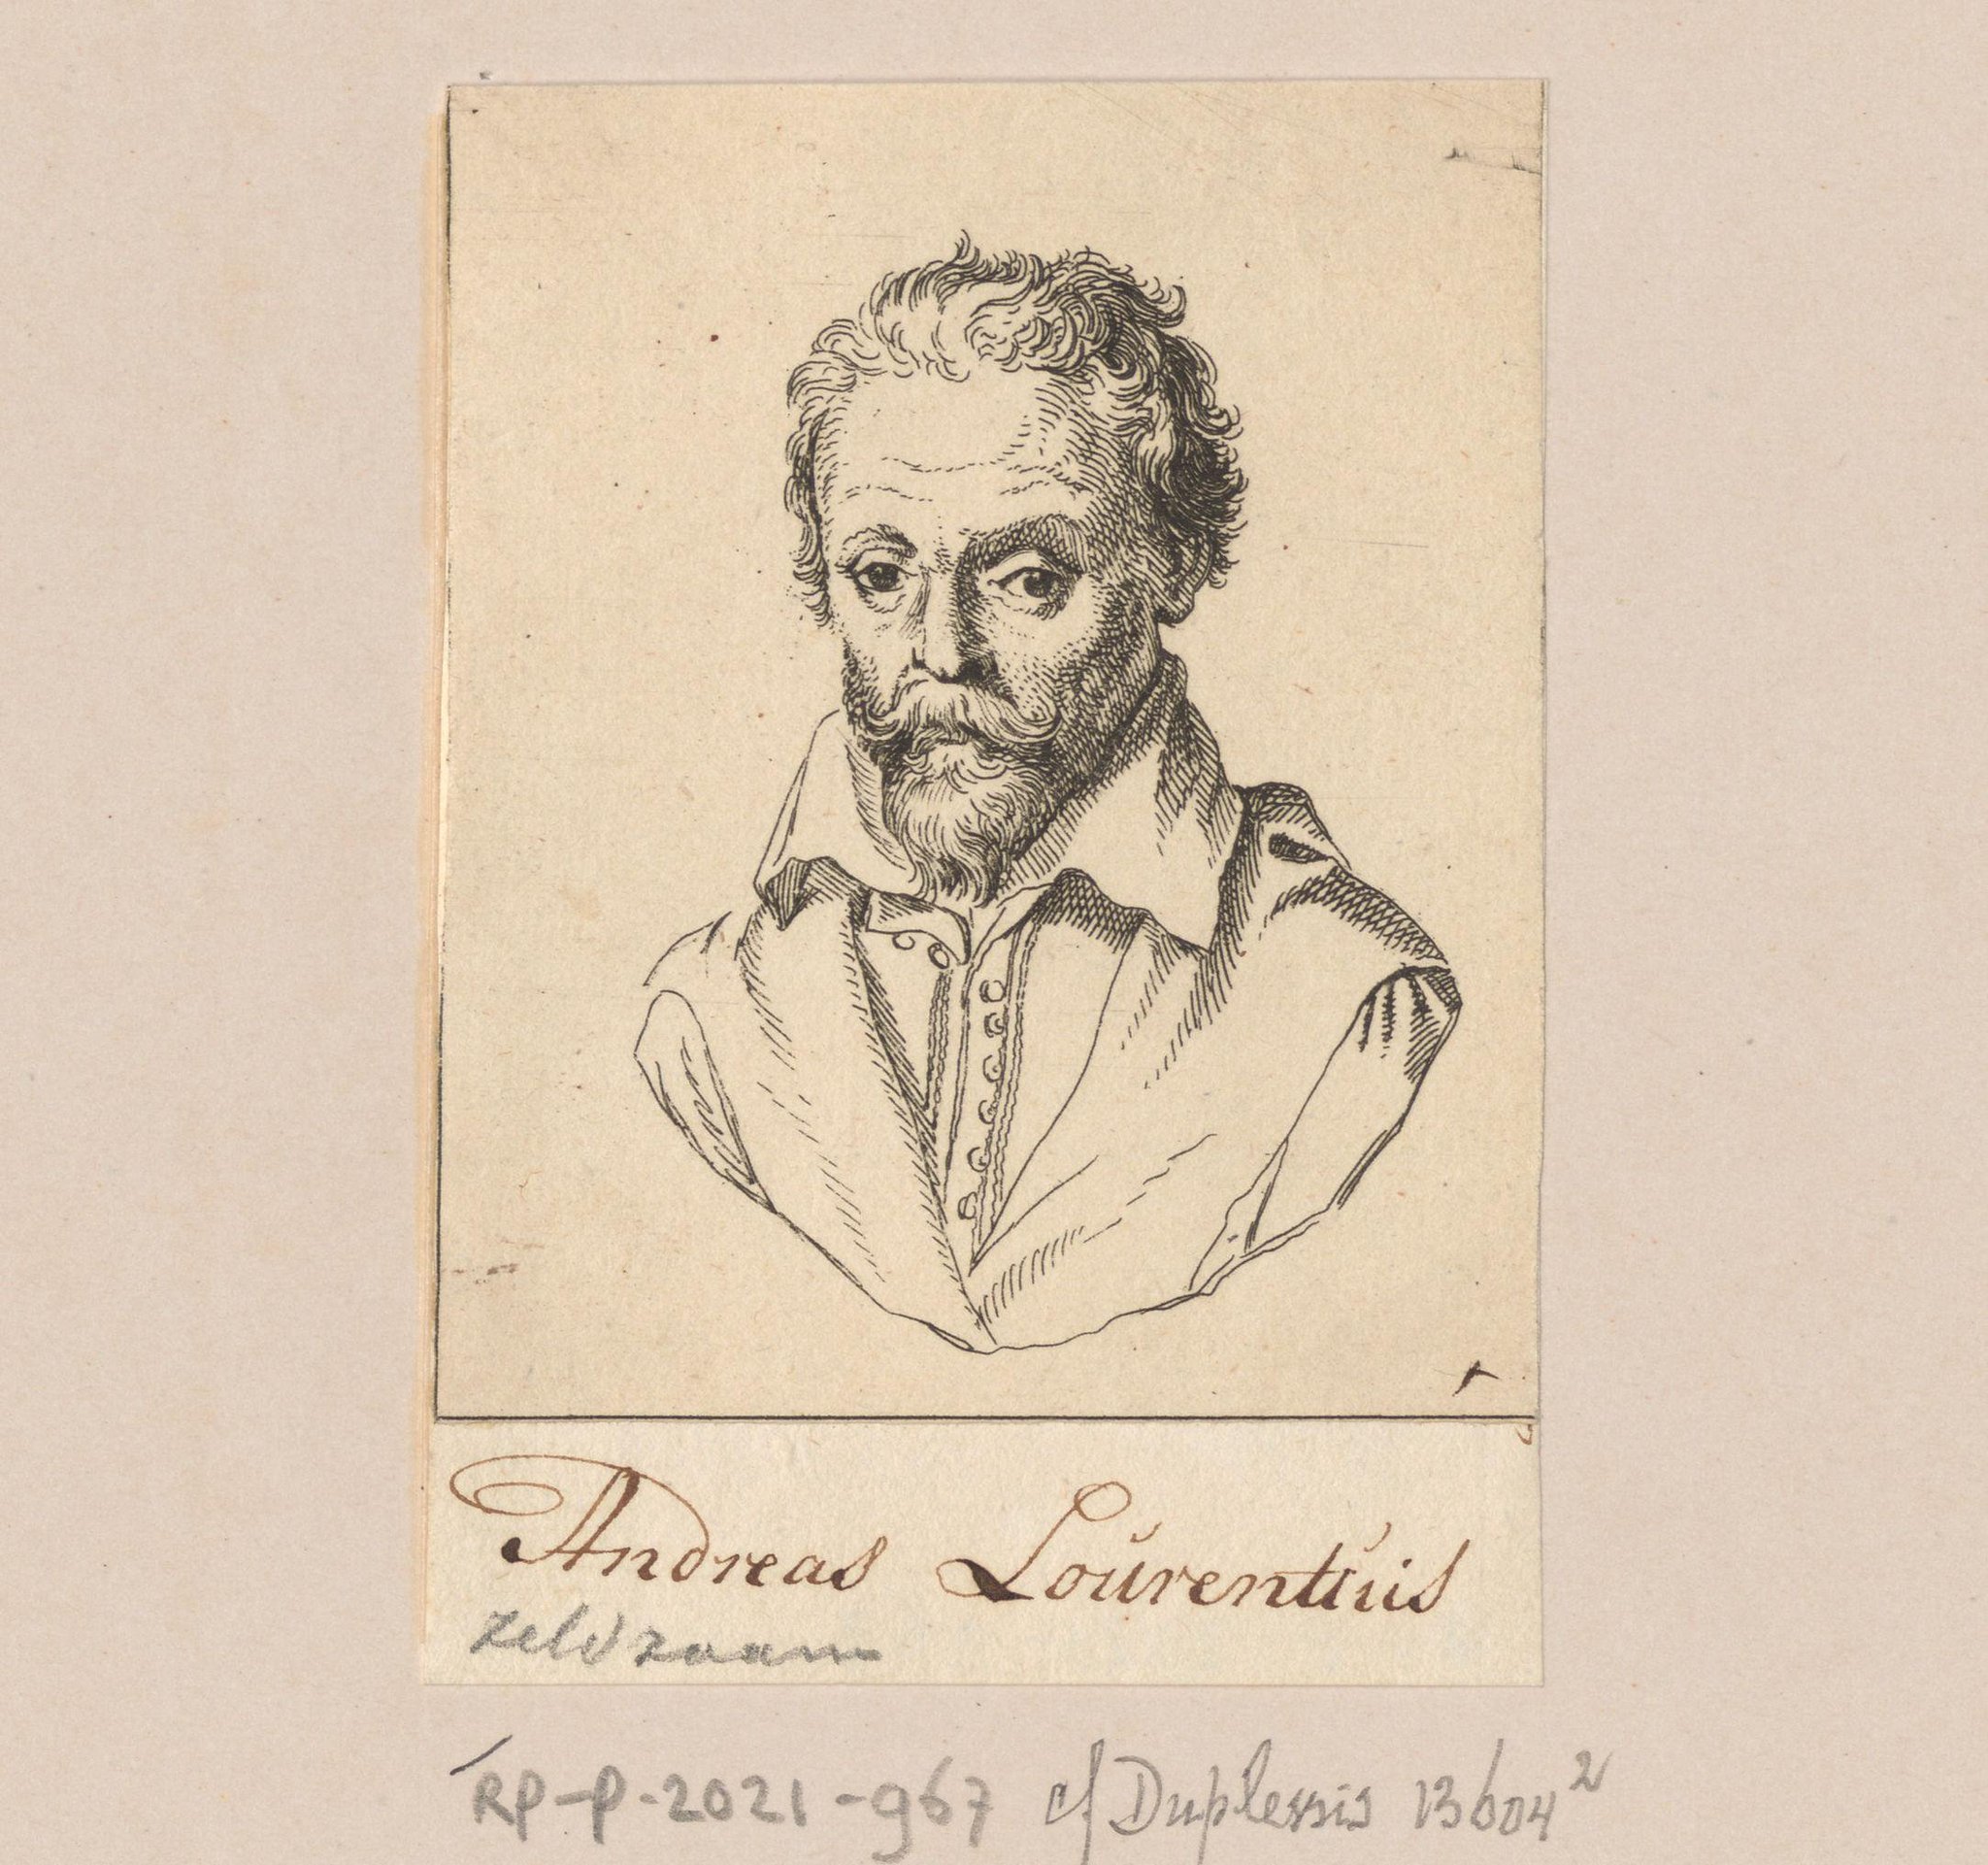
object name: print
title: Portret van André du Laurens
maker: Anonymous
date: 1600-1699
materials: paper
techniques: etching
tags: historical persons, physician, doctor (+ portrait of scholar, scientist)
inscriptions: inscription: ‘zeldzaam’, inscription: ‘Andreas Lourentius’